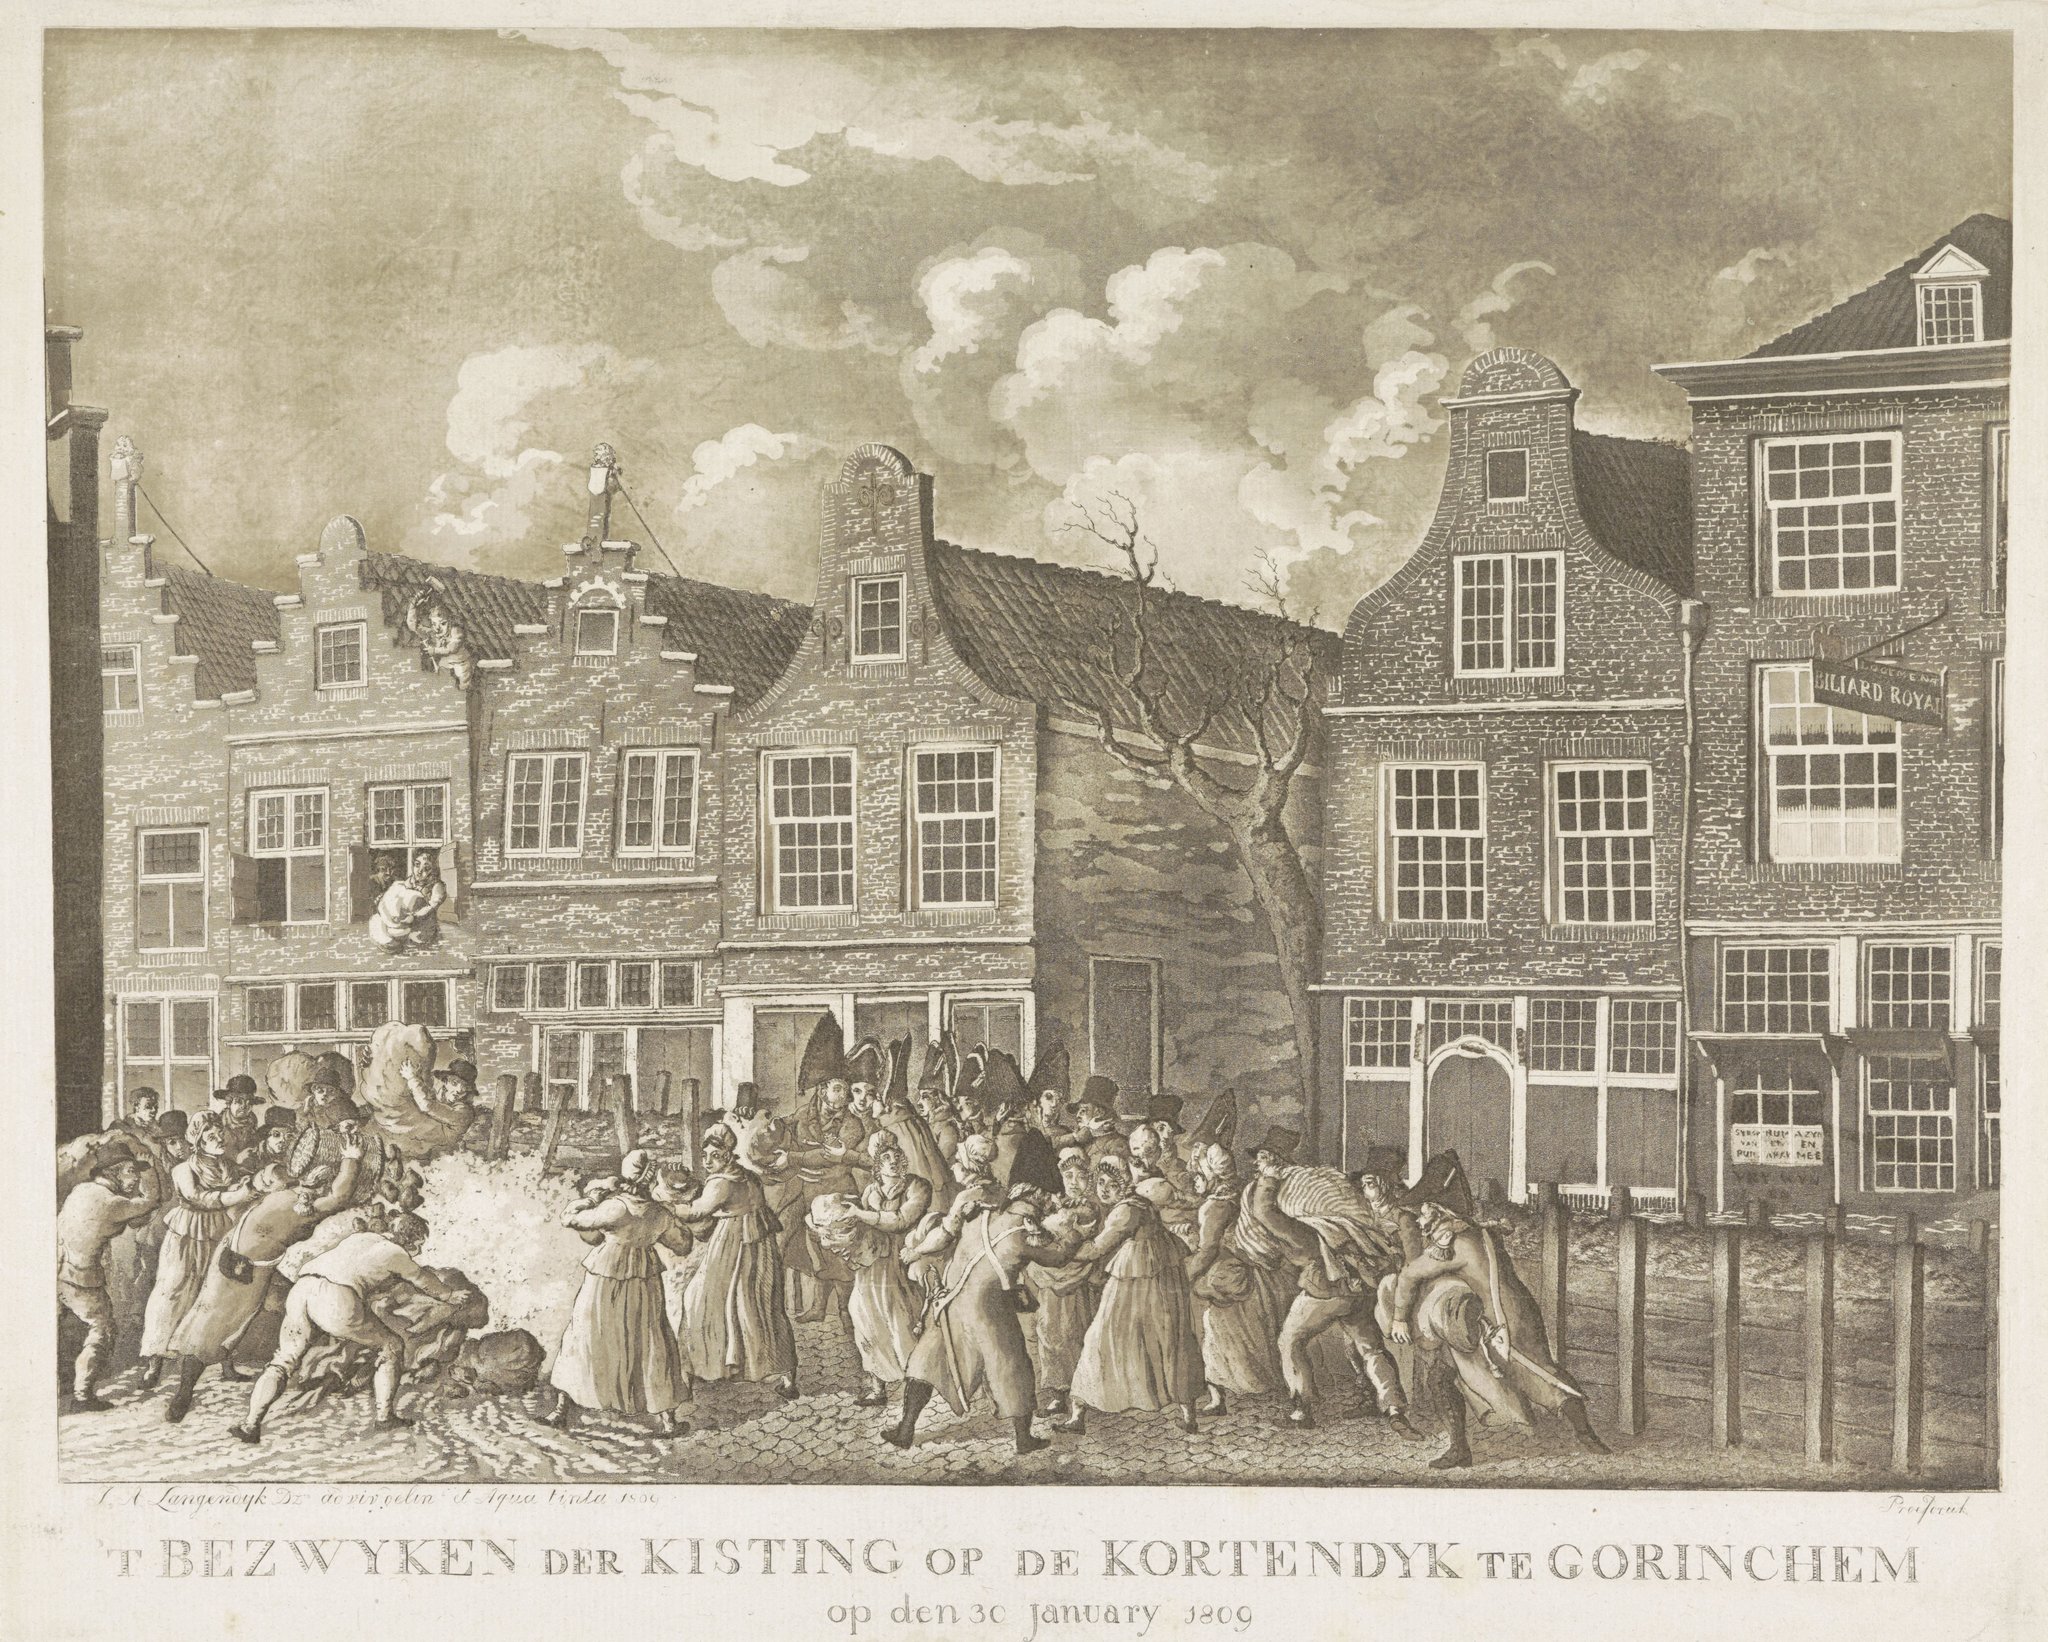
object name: print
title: 't Bezwyken der Kisting op de Kortendyk te Gorinchem op den 30 january 1809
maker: jan anthonie langendijk dzn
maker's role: draughtsman, print maker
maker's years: 1780-1818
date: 1809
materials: paper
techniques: aquatint, etching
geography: netherlands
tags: dike-break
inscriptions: collector's mark: Lugt 2228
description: Watersnood in de straten van de stad Gorinchem als de bekisting langs de Kortendijk bezwijkt, januari 1809. Mensen dragen zakken met stenen aan om de doorbraak te stoppen. Rechts het logement 'De dubbele arend'. Met pendant.